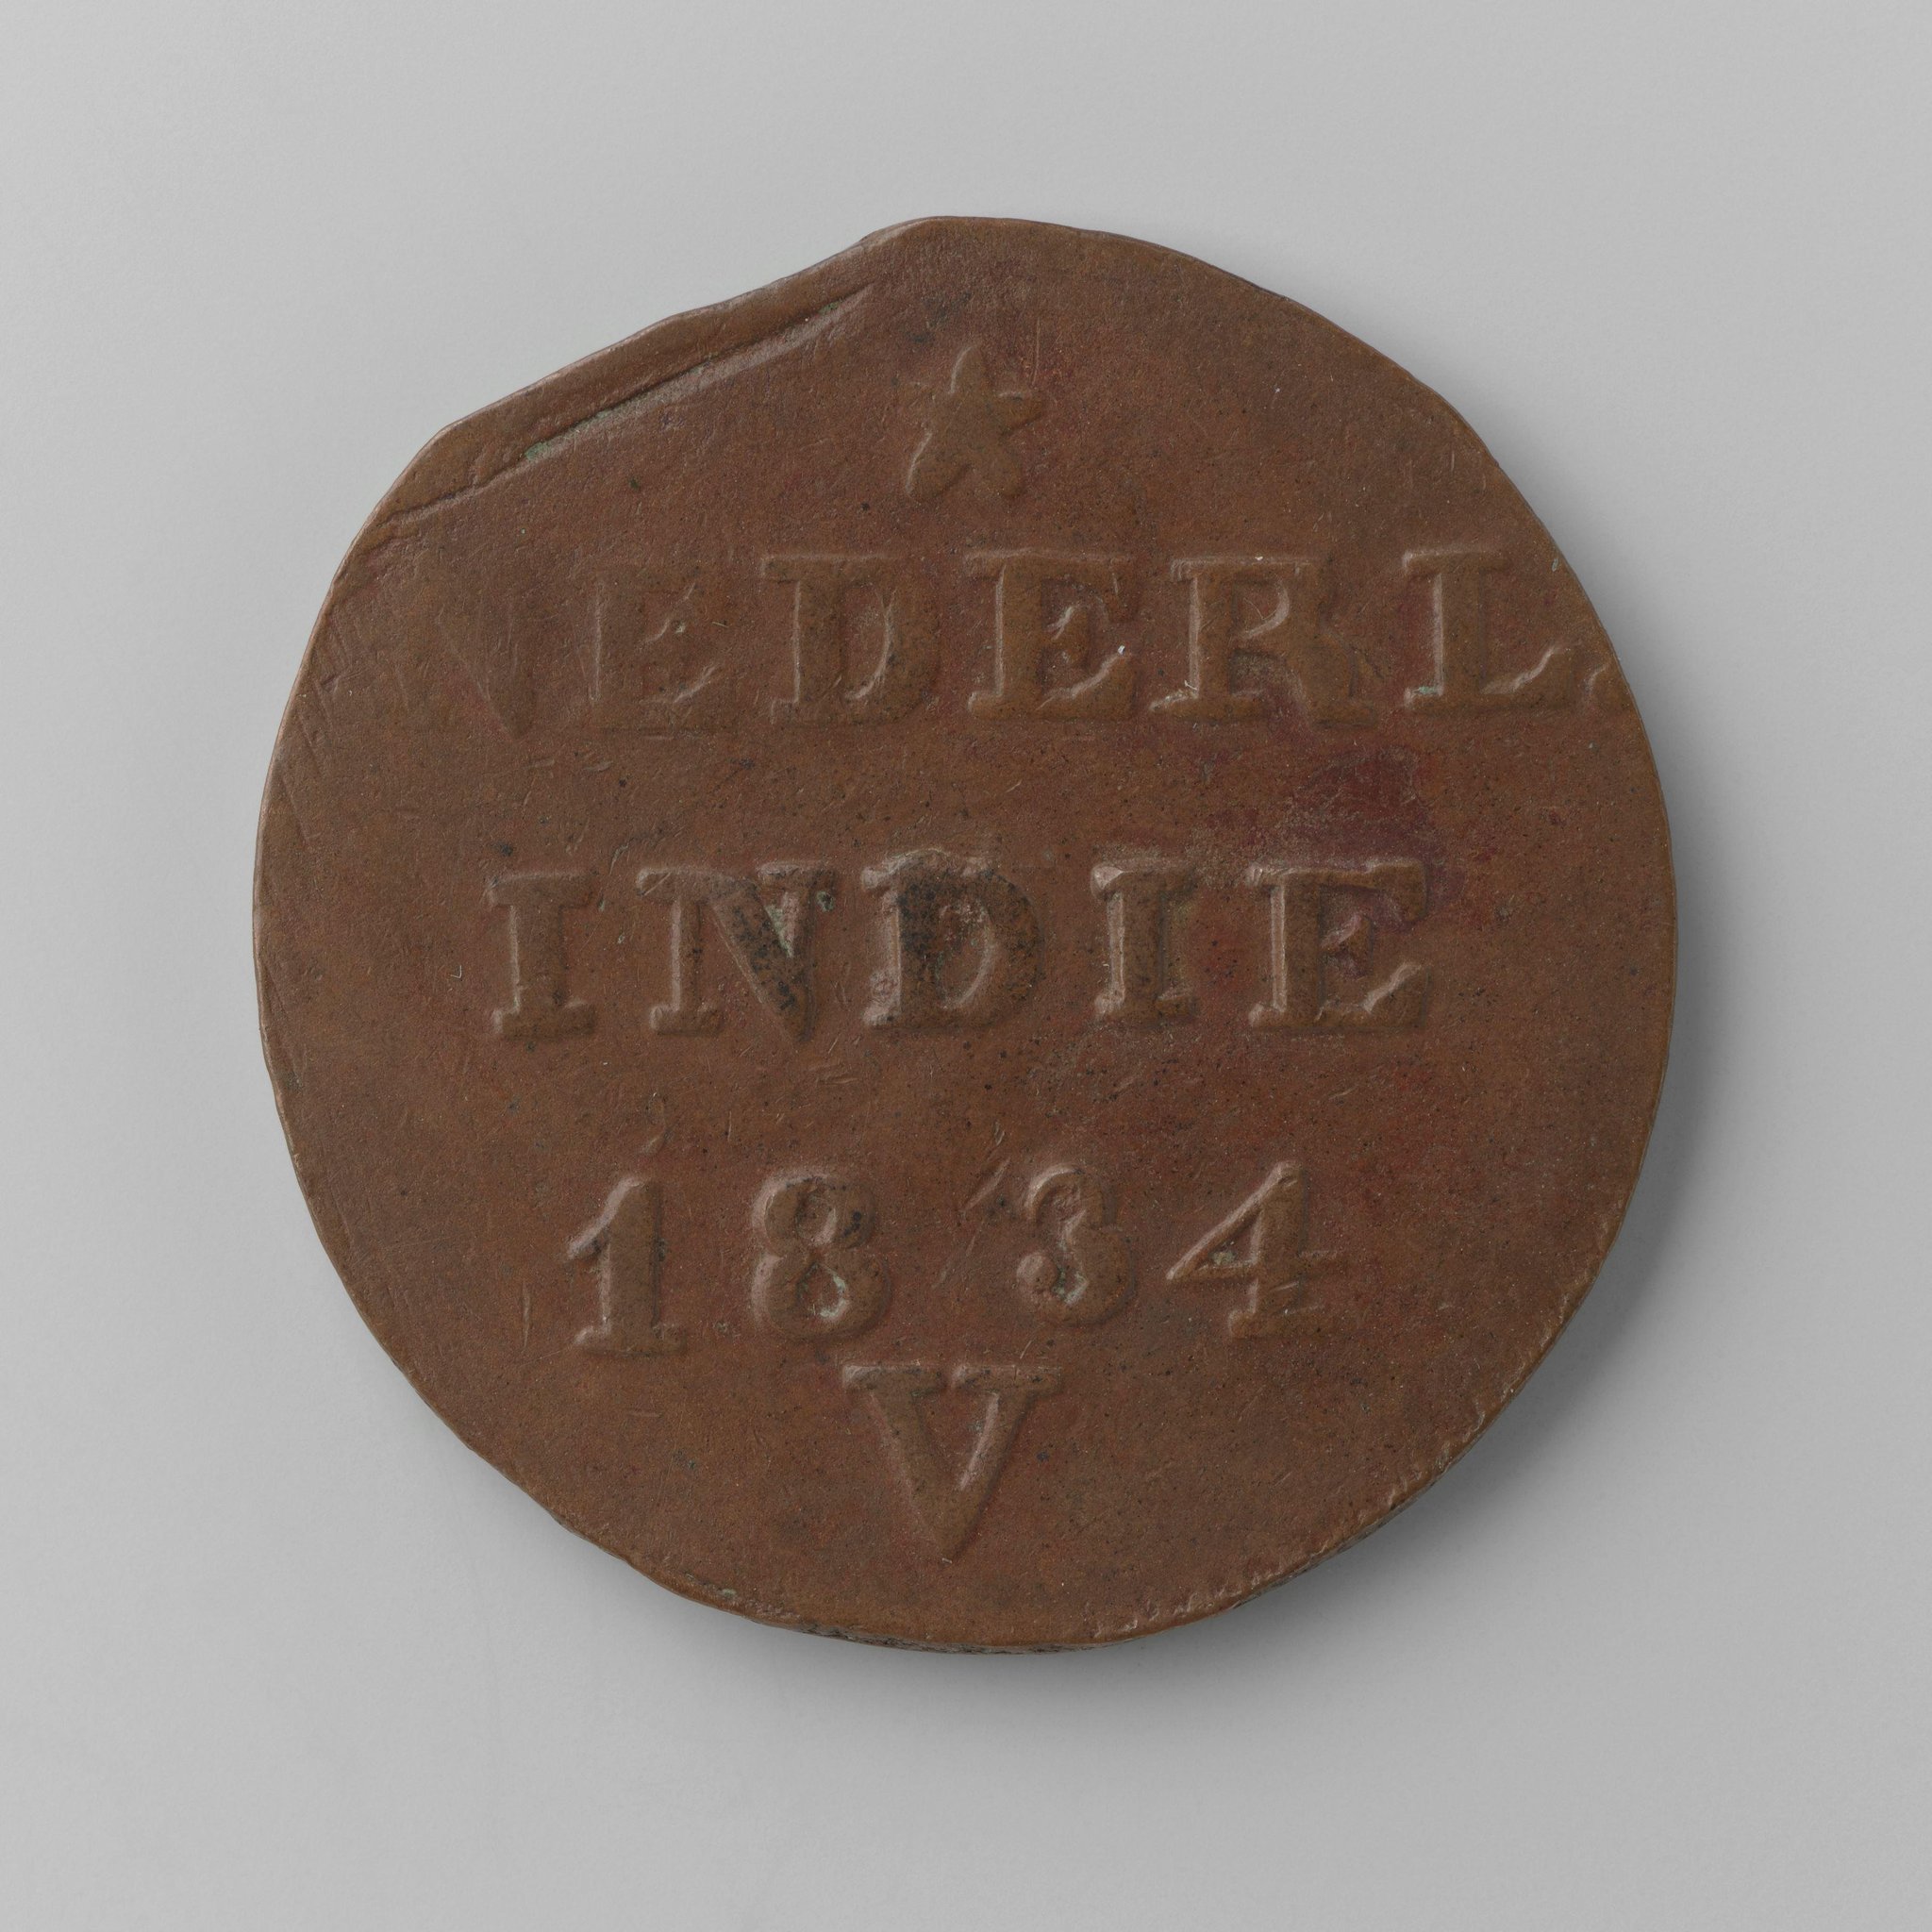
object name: coin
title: 2 cent van Nederlands Indië,1834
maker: william i of the netherlands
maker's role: koning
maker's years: 1772-1843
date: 1834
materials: copper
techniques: striking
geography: surabaya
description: Koperen munt. Voorzijde: tussen waarde-aanduiding 2 CT. gekroond rijkswapenschild. Keerzijde: tweeregelig opschrift, waarboven muntteken en waaronder jaartal. Daaronder letter V [=muntmeester De Vogel]. Gladde rand.